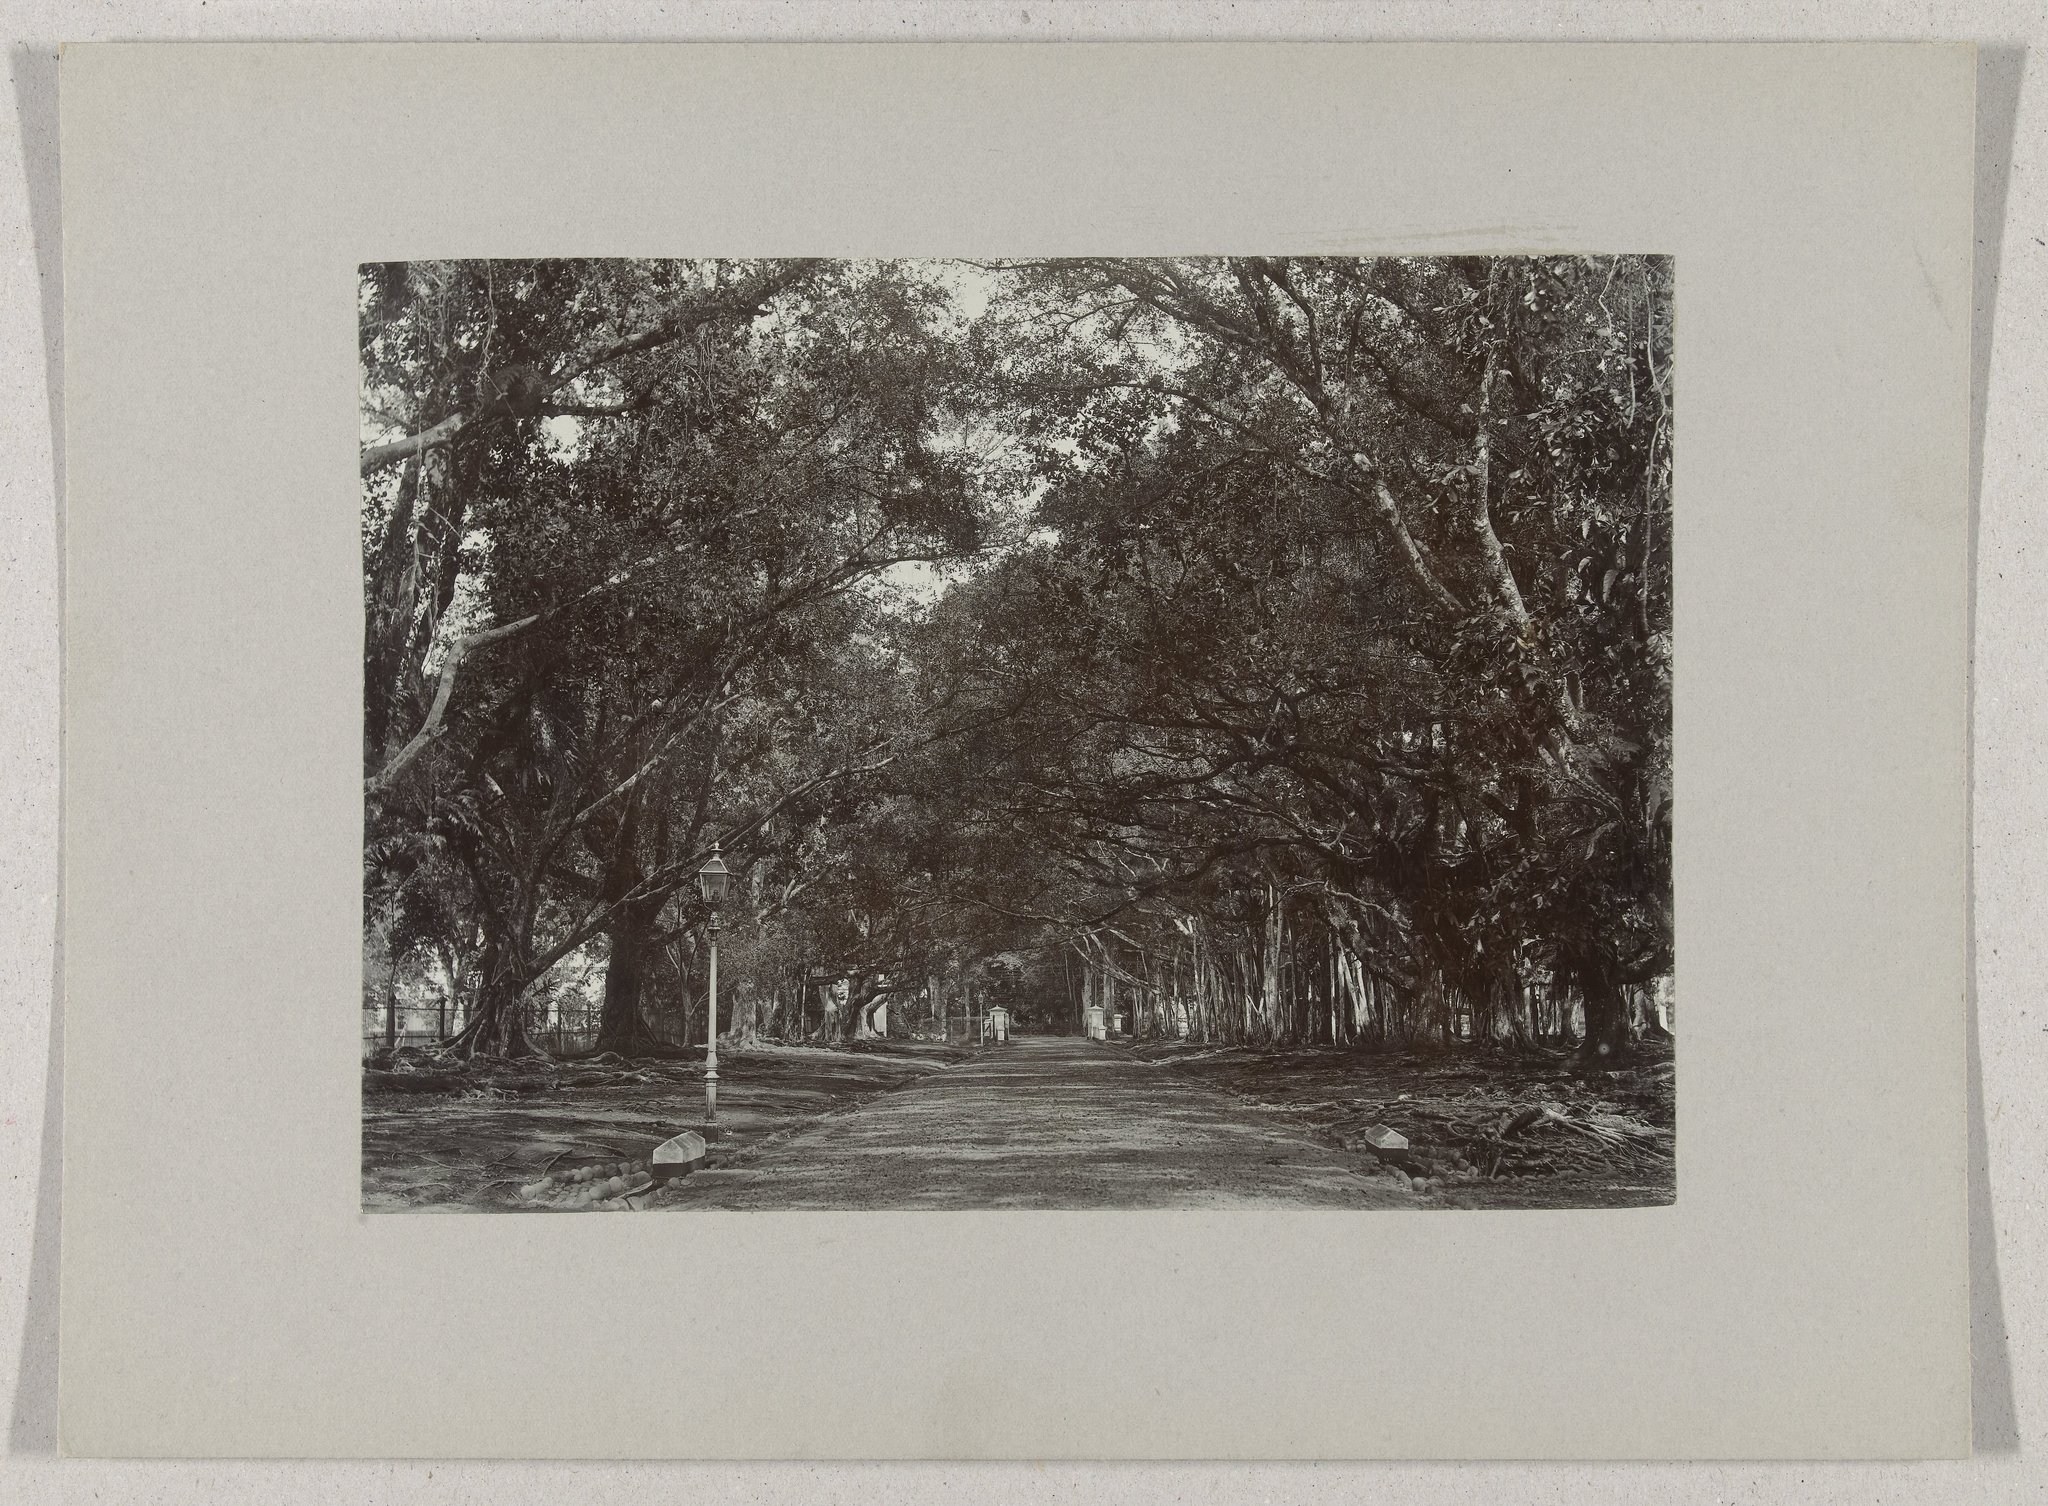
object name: photograph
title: De Waringinlaan in de botanische tuin in Buitenzorg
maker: Anonymous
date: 1895-1915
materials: cardboard, paper, photographic support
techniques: gelatin silver print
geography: buitenzorg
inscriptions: annotation: ‘48. Buitenzorg. Plantentuin’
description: De Waringinlaan in de botanische tuin te Buitenzorg (Bogor), Nederlands-Indië